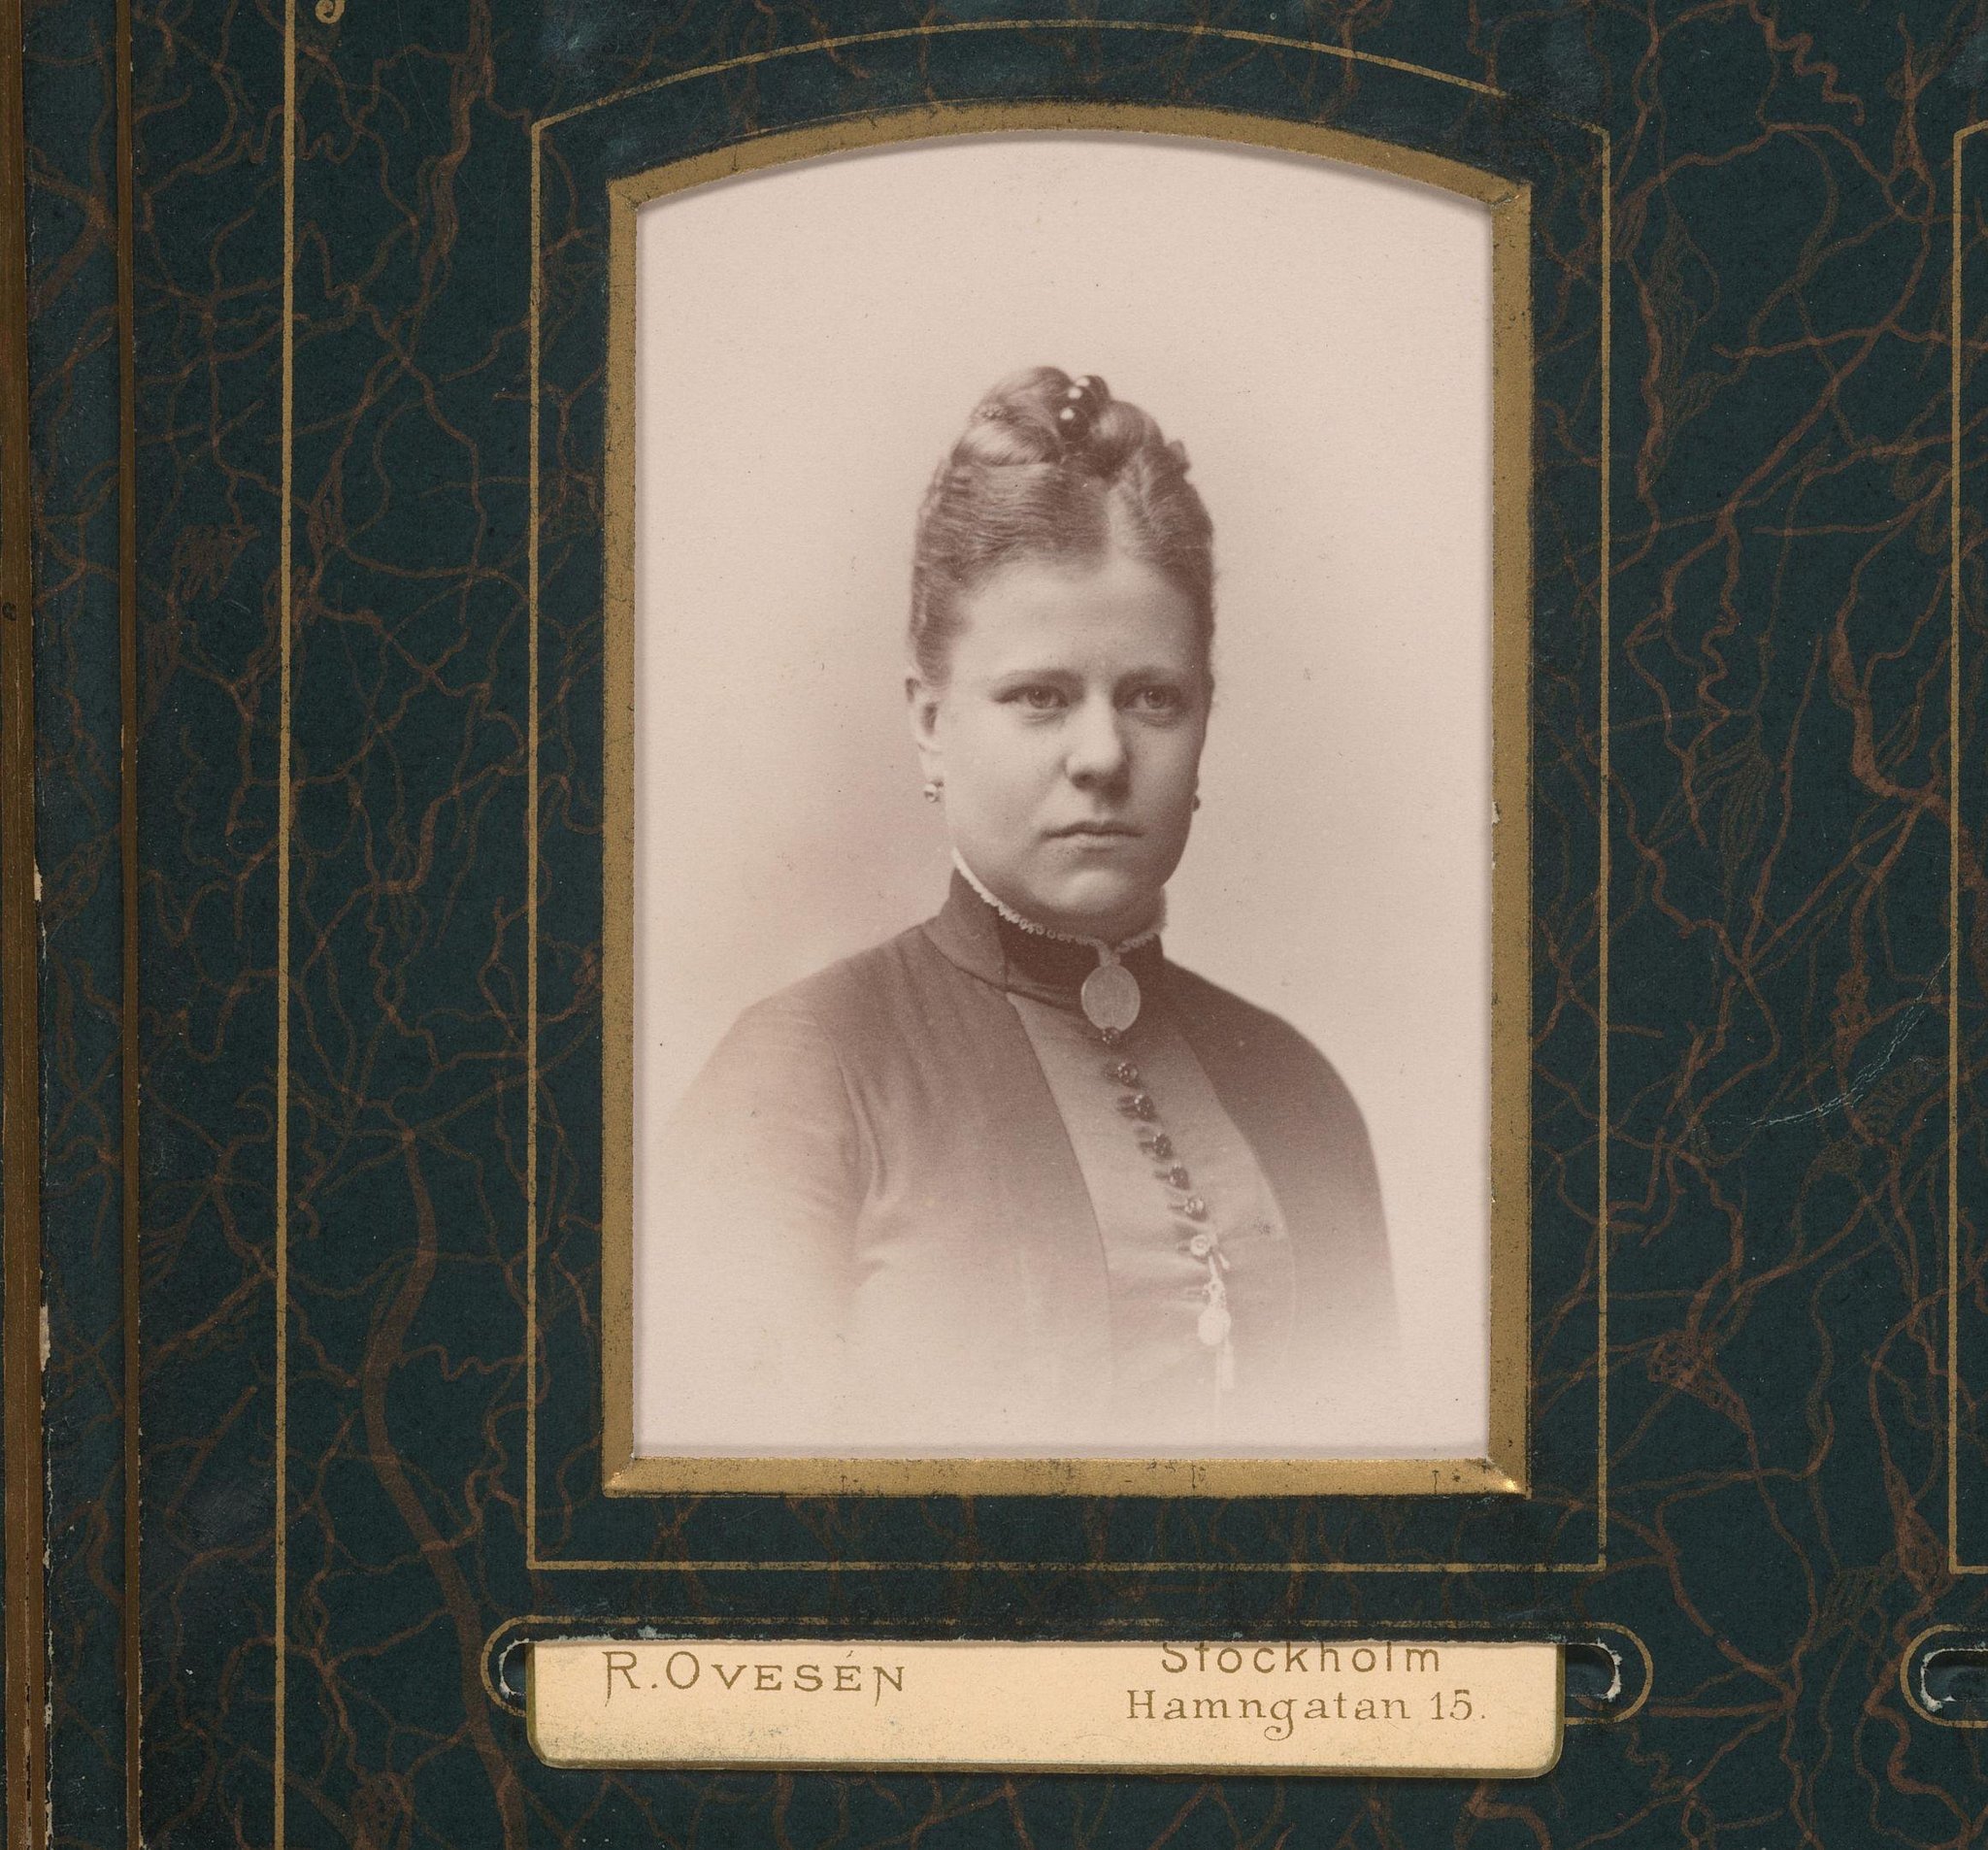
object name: carte de visite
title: Portret van een vrouw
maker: rasmus ovesén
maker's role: fotograaf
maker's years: 1843-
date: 1860-1900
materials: cardboard, photographic support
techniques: albumen print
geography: stockholm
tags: historical persons - bb - woman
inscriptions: inscription: ‘R. Ovesén/ HAMNGATAN No. 15/ HÖRNET AF MALMSKILNADSGATAN/ STOCKHOLM/ TELEFON No 55. 99.’